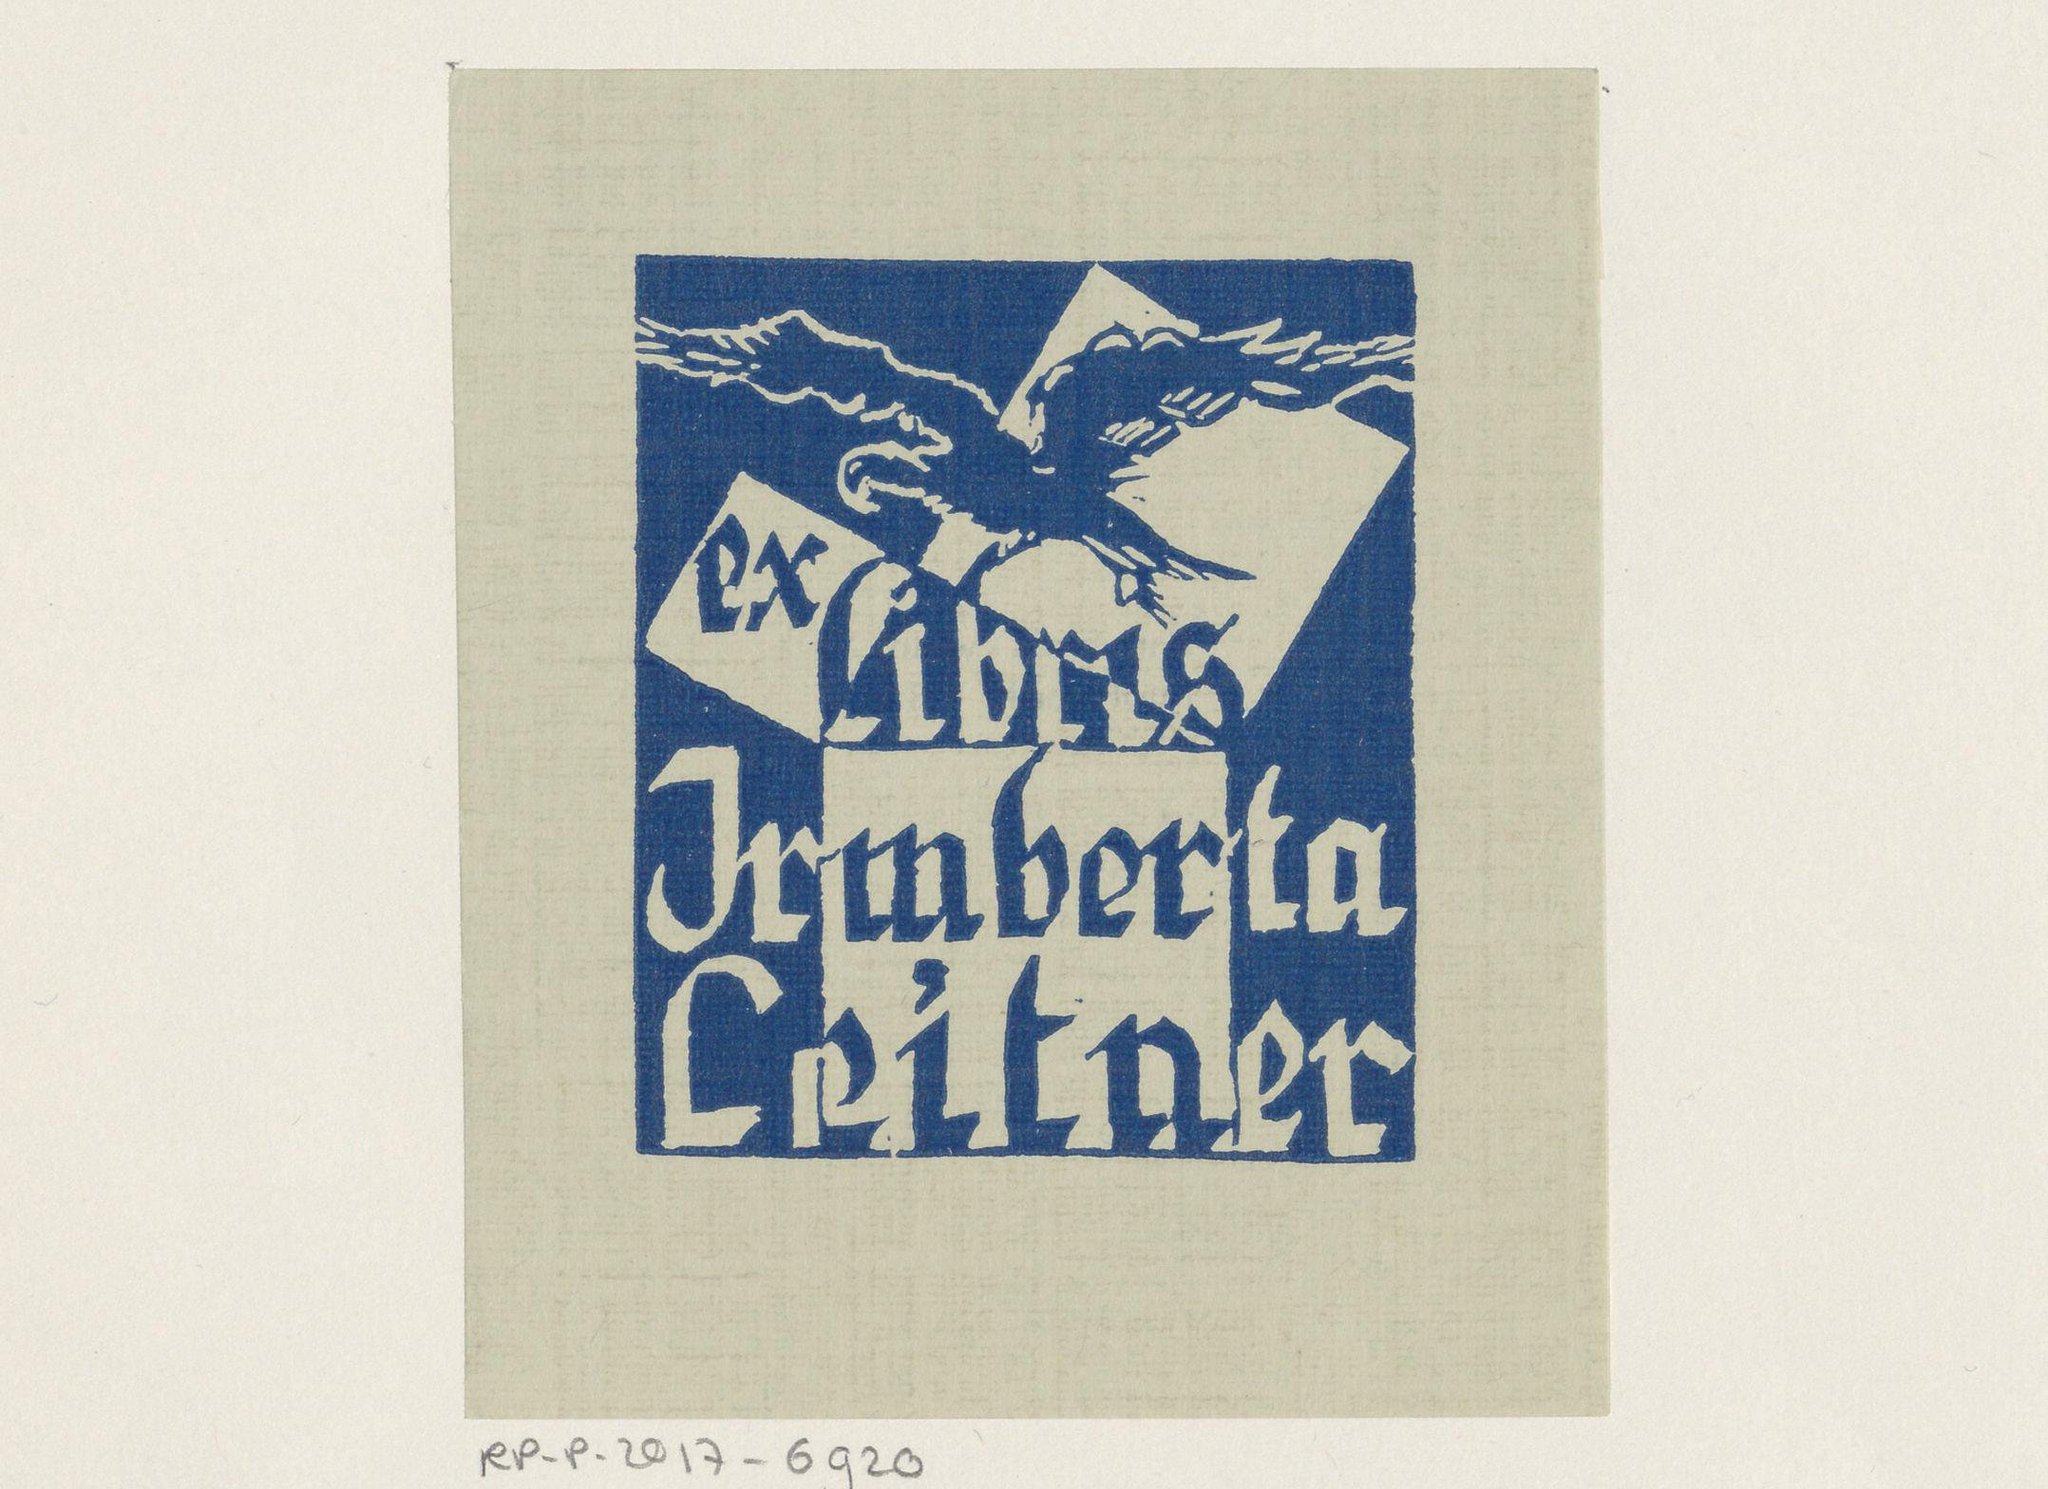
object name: bookplate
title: Ex libris van Irmberta Leitner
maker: karl bock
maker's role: print maker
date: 1937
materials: paper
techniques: linocut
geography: vienna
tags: predatory birds: eagle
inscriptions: inscription: ‘karl bock . wien/ linolschnitt 1937’